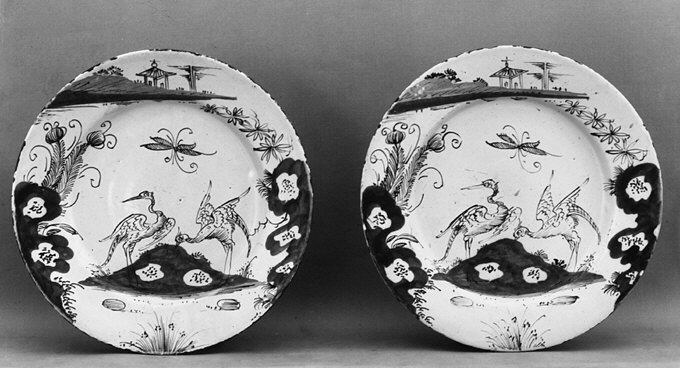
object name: plate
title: Plate (one of a pair)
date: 1701-1800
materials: earthenware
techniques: glazing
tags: birds,butterflies,flowers